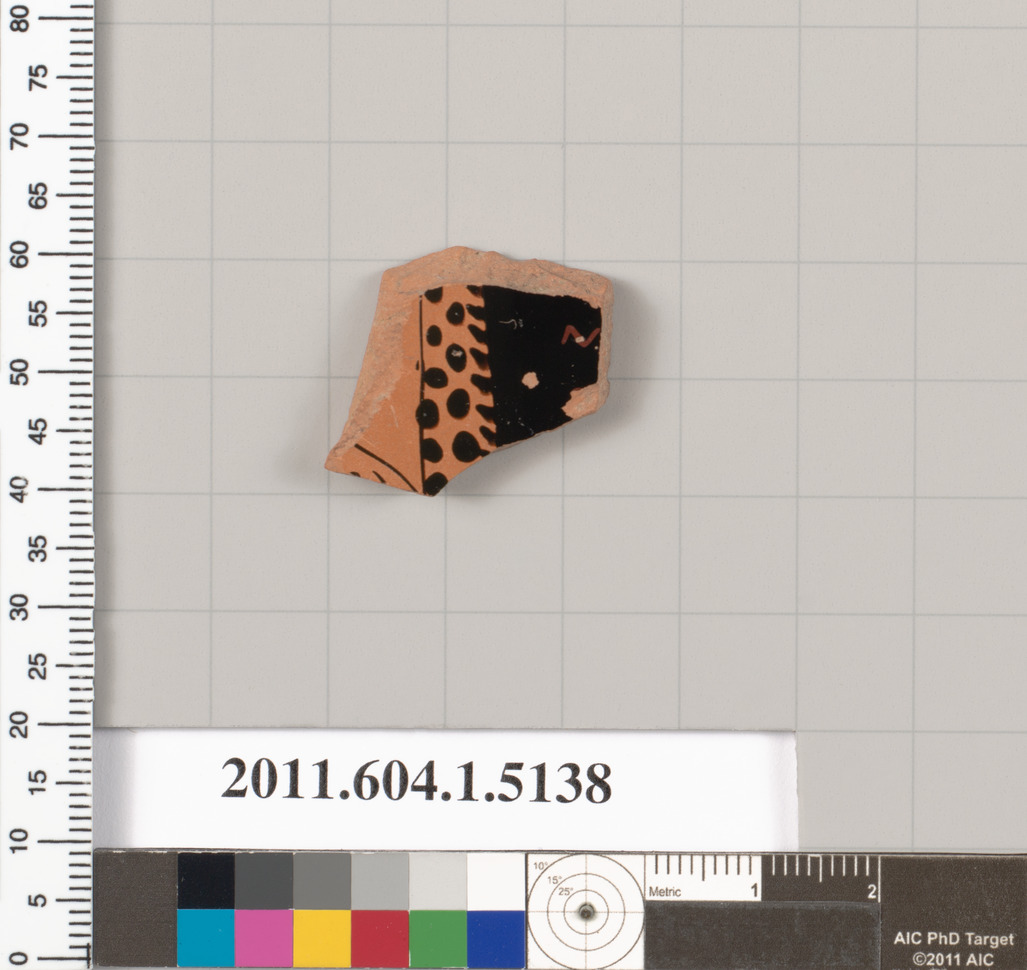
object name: kylix fragment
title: Terracotta fragment of a kylix (drinking cup)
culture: greek, attic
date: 500-480 BCE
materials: terracotta